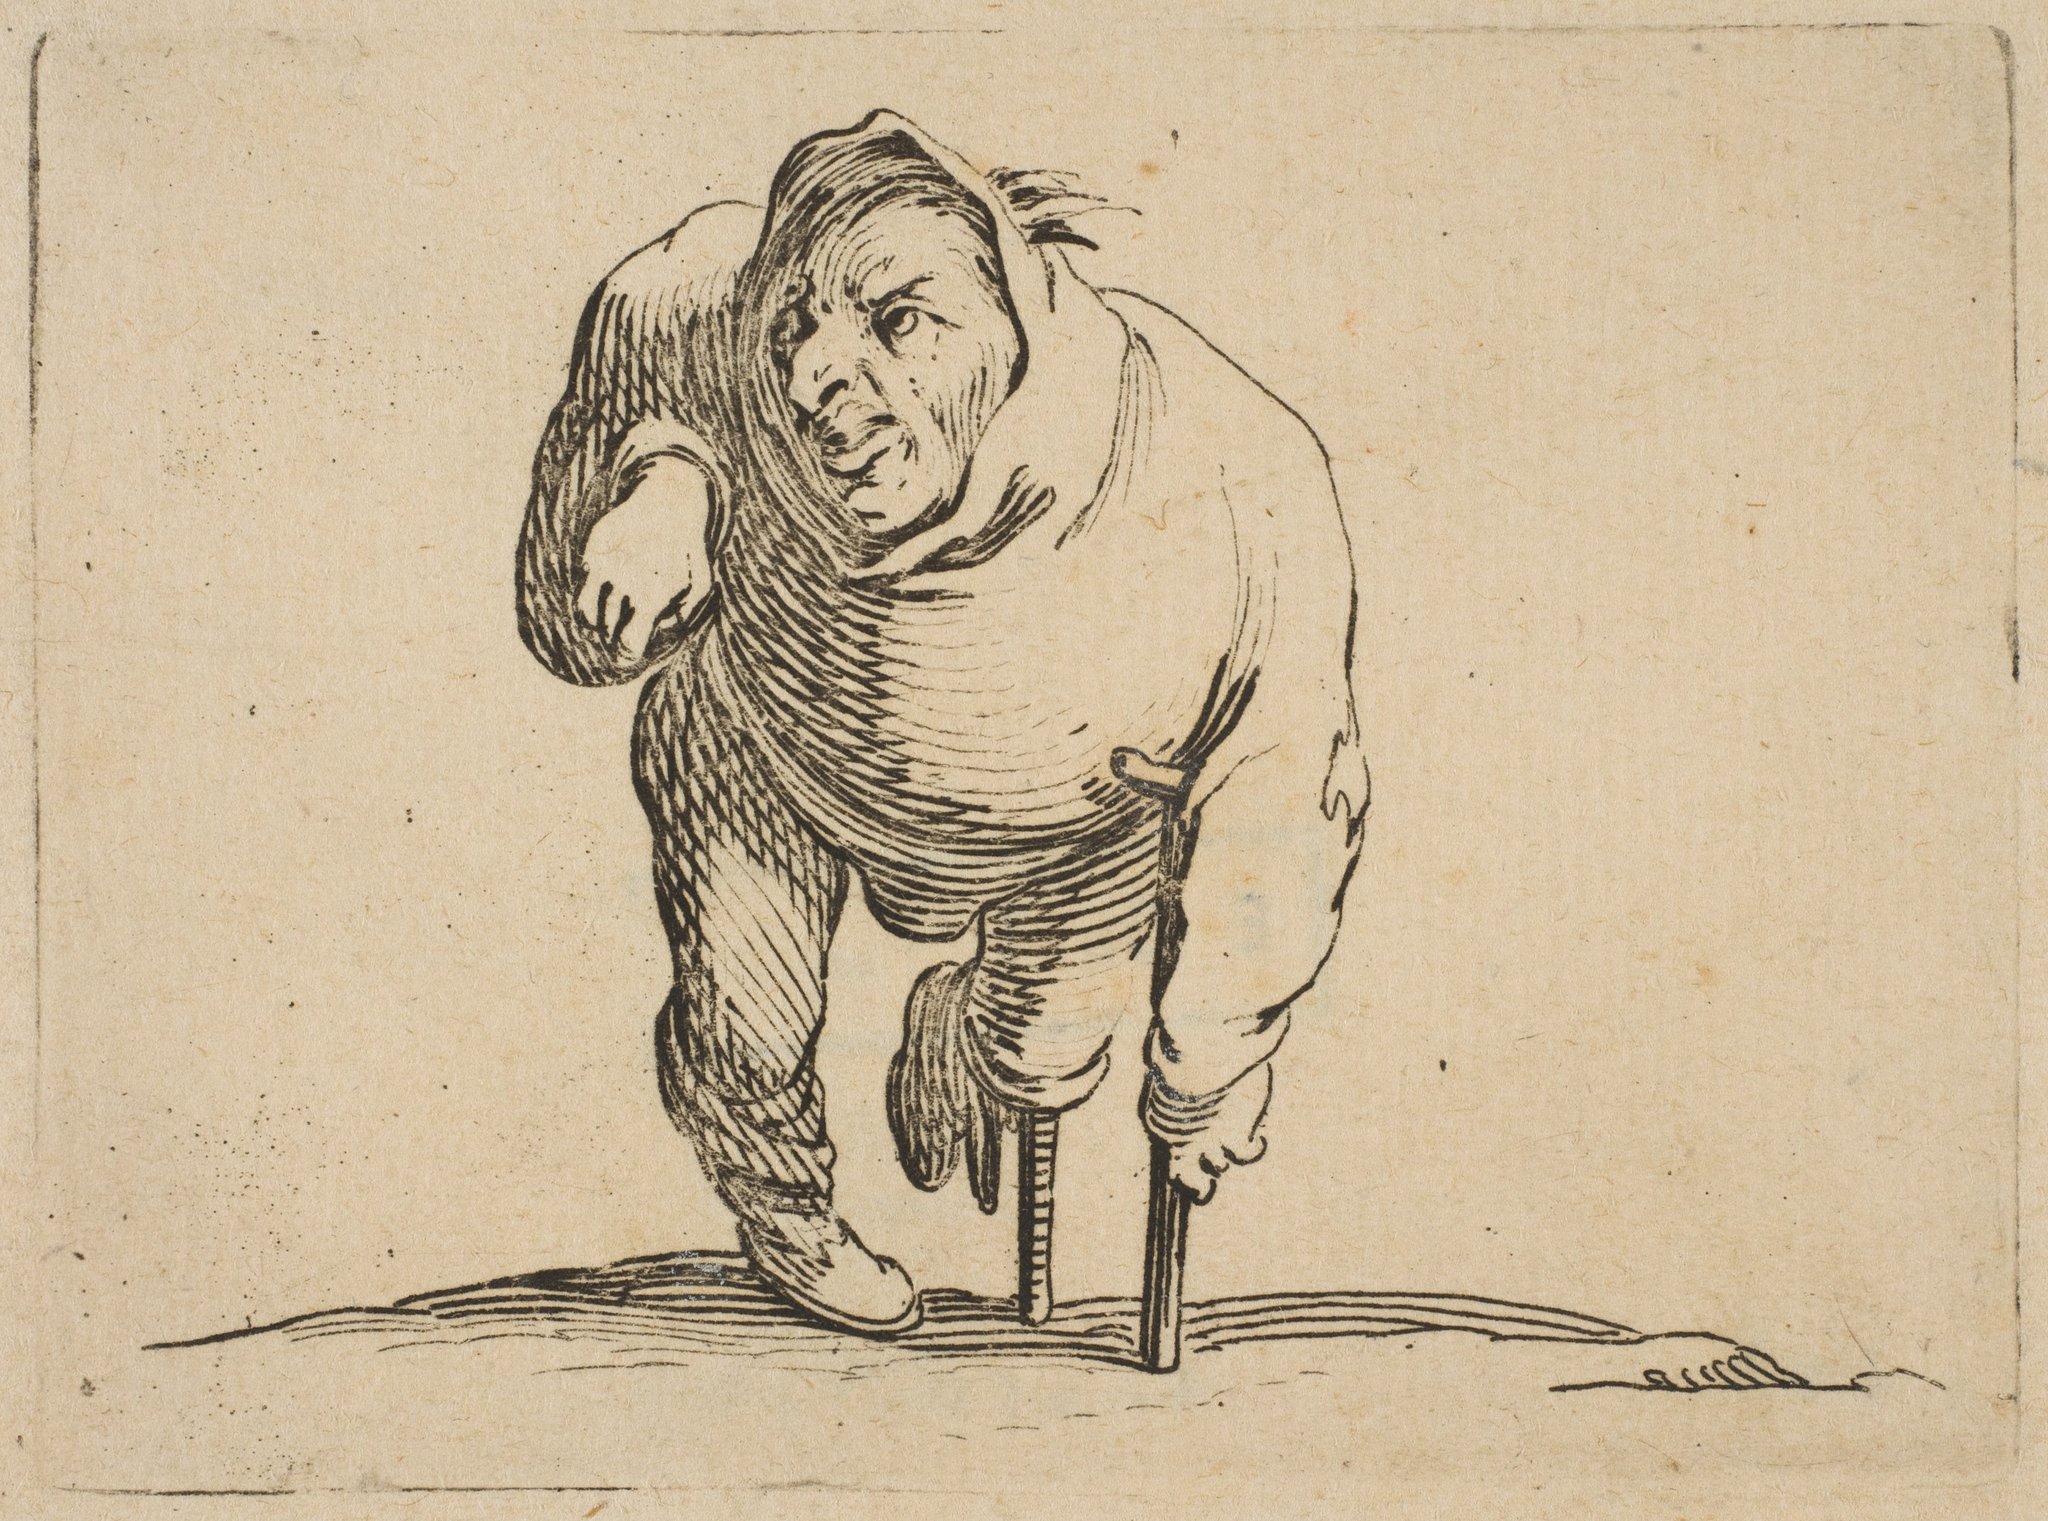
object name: print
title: L'Estropié a la Béquille et a La Jambe de Bois (The Cripple with a Crutch and a Wooden Leg), from "Varie Figure Gobbi, suite appelée aussi Les Bossus, Les Pygmées, Les Nains Grotesques" (Various Hunchbacked Figures, The Hunchbacks, The Pygmes, The Grotesque Dwarfs)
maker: jacques callot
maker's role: artist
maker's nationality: french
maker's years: 1592-1635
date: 1616-1622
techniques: engraving, etching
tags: men